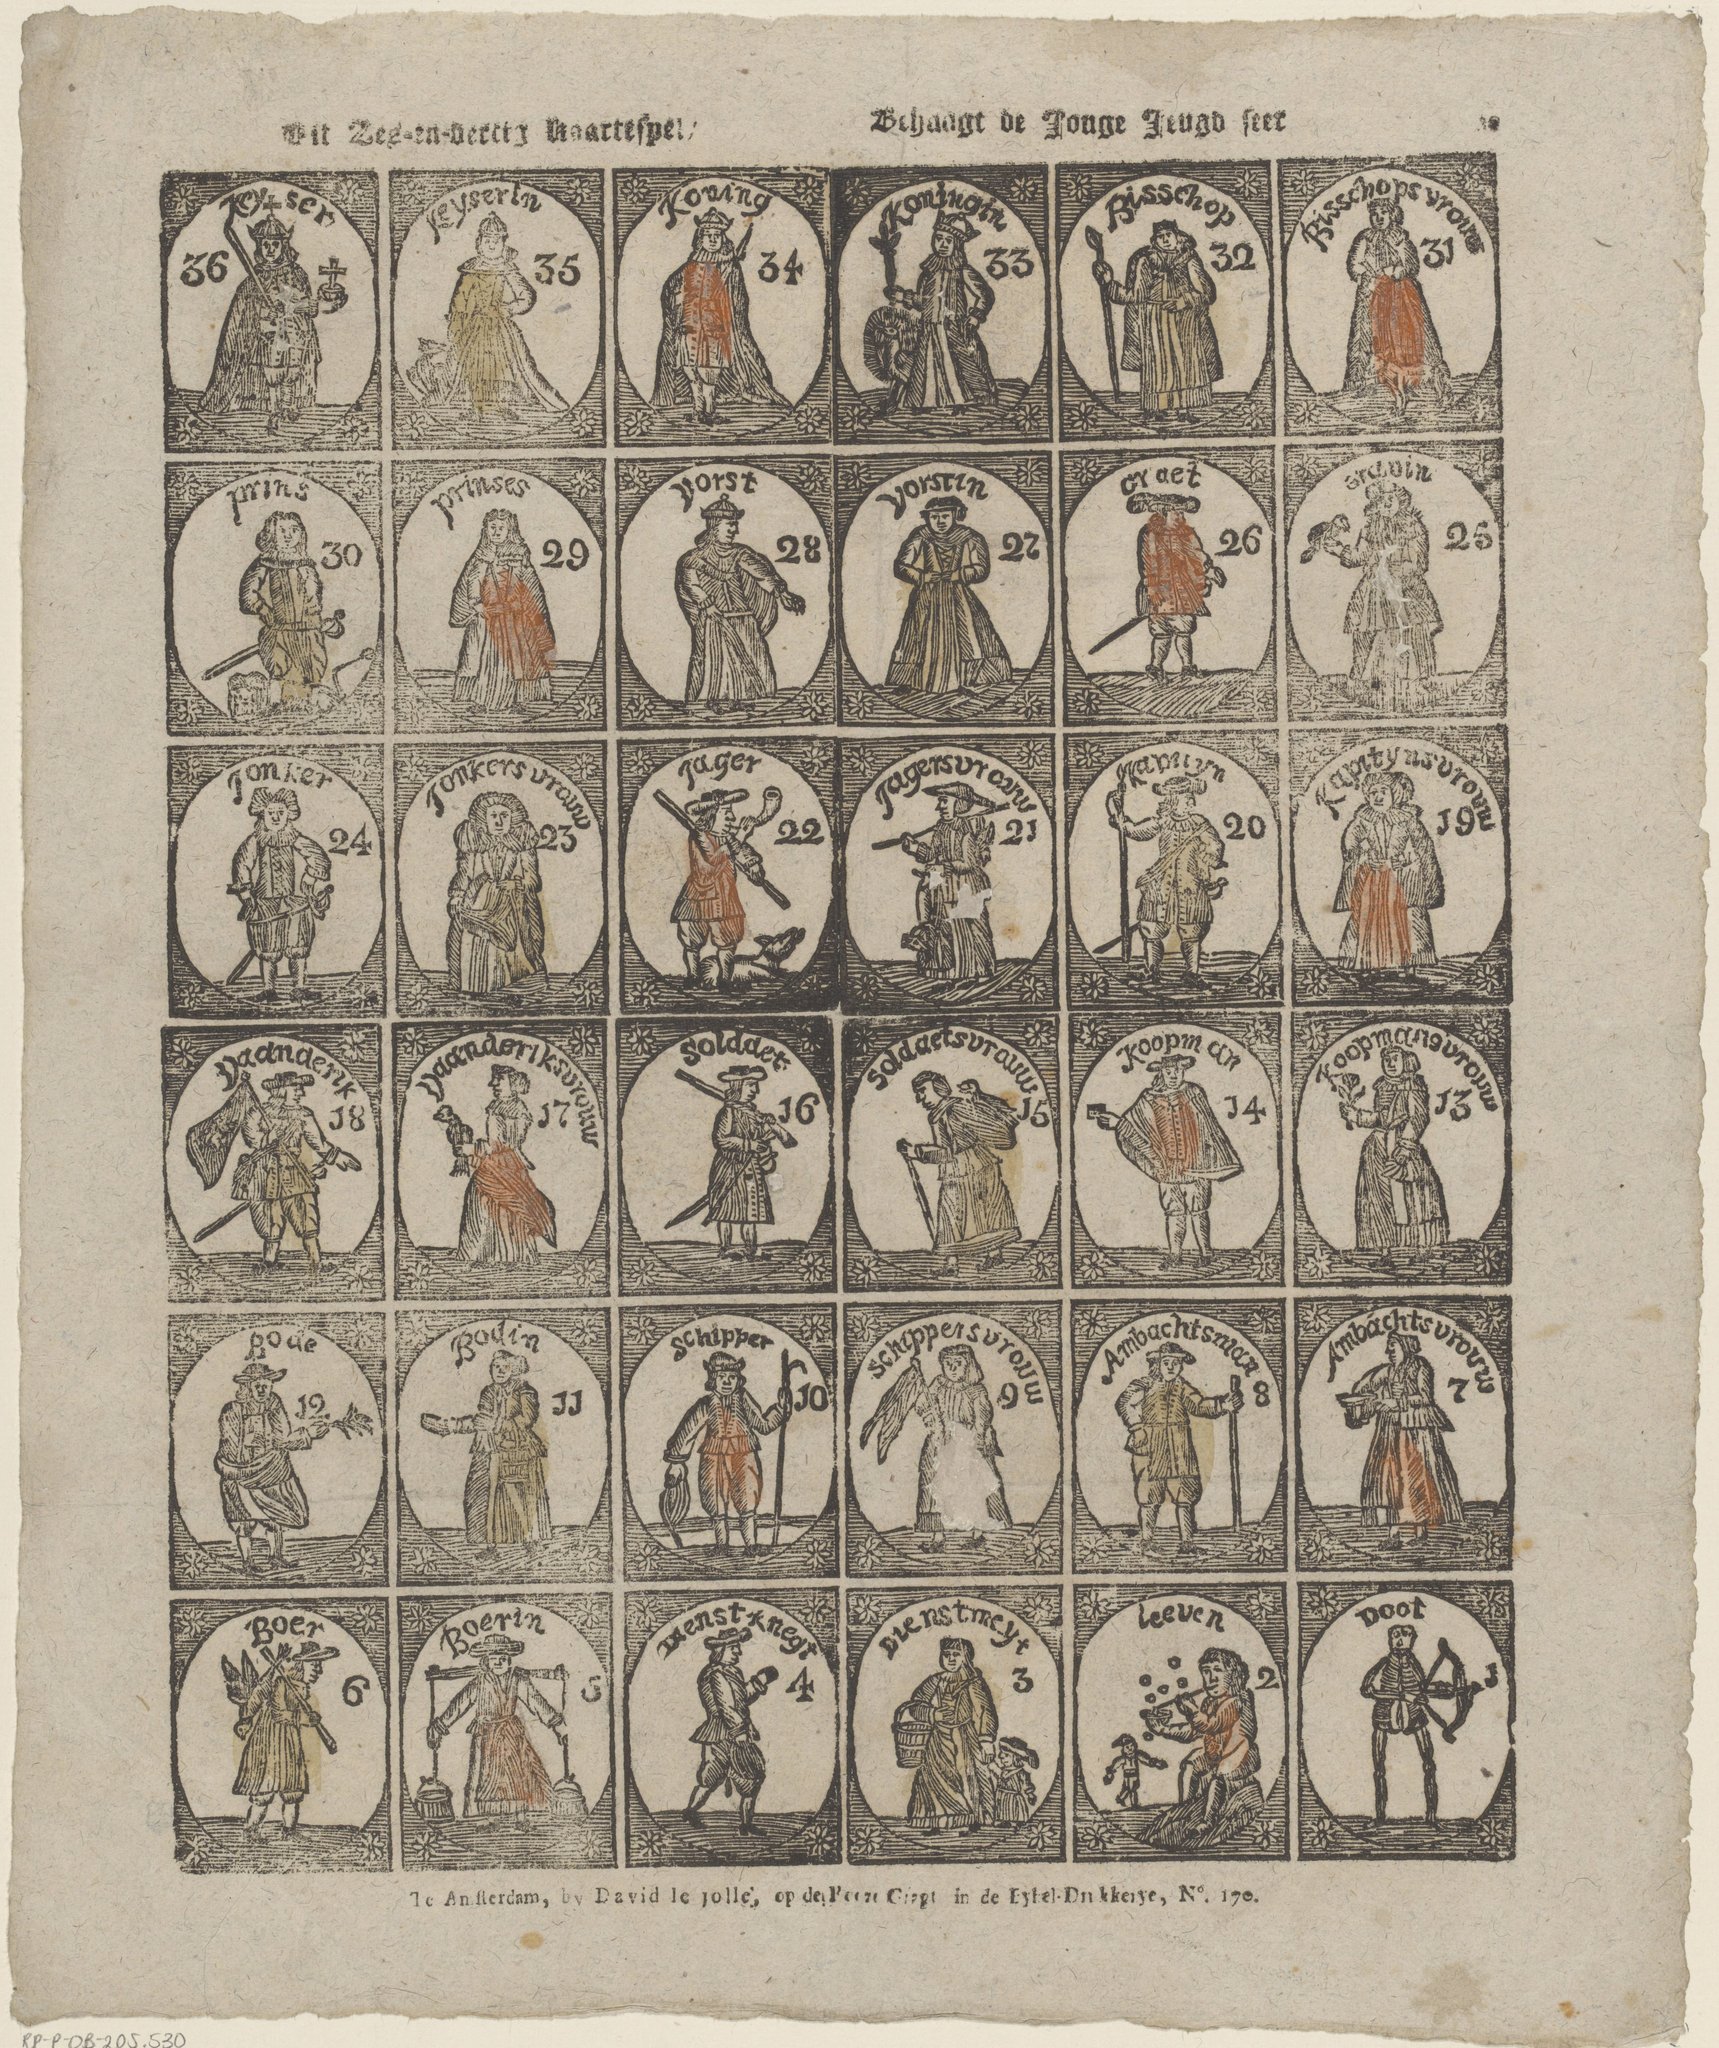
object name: popular print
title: Floskaartjes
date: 1814-1820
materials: paper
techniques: colour, letterpress printing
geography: netherlands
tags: symbols and personifications of death, social position, card games, nobility and patriciate; chivalry, knighthood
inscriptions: collector's mark: Lugt 2760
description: Blad met 36 speelkaarten (floskaartjes) met voorstellingen van verschillende figuren. De afbeeldingen vormen achttien paren, aflopend genummerd van bovenaan links nummer 36 tot onderaan rechts nummer 1. Op de twee laagste nummers na tonen ze zeventien koppels, man en vrouw, met de man net één nummer hoger dan de vrouw, waarbij elk paar een beroep of een maatschappelijke positie voorstelt. Genummerd rechtsboven: 30.